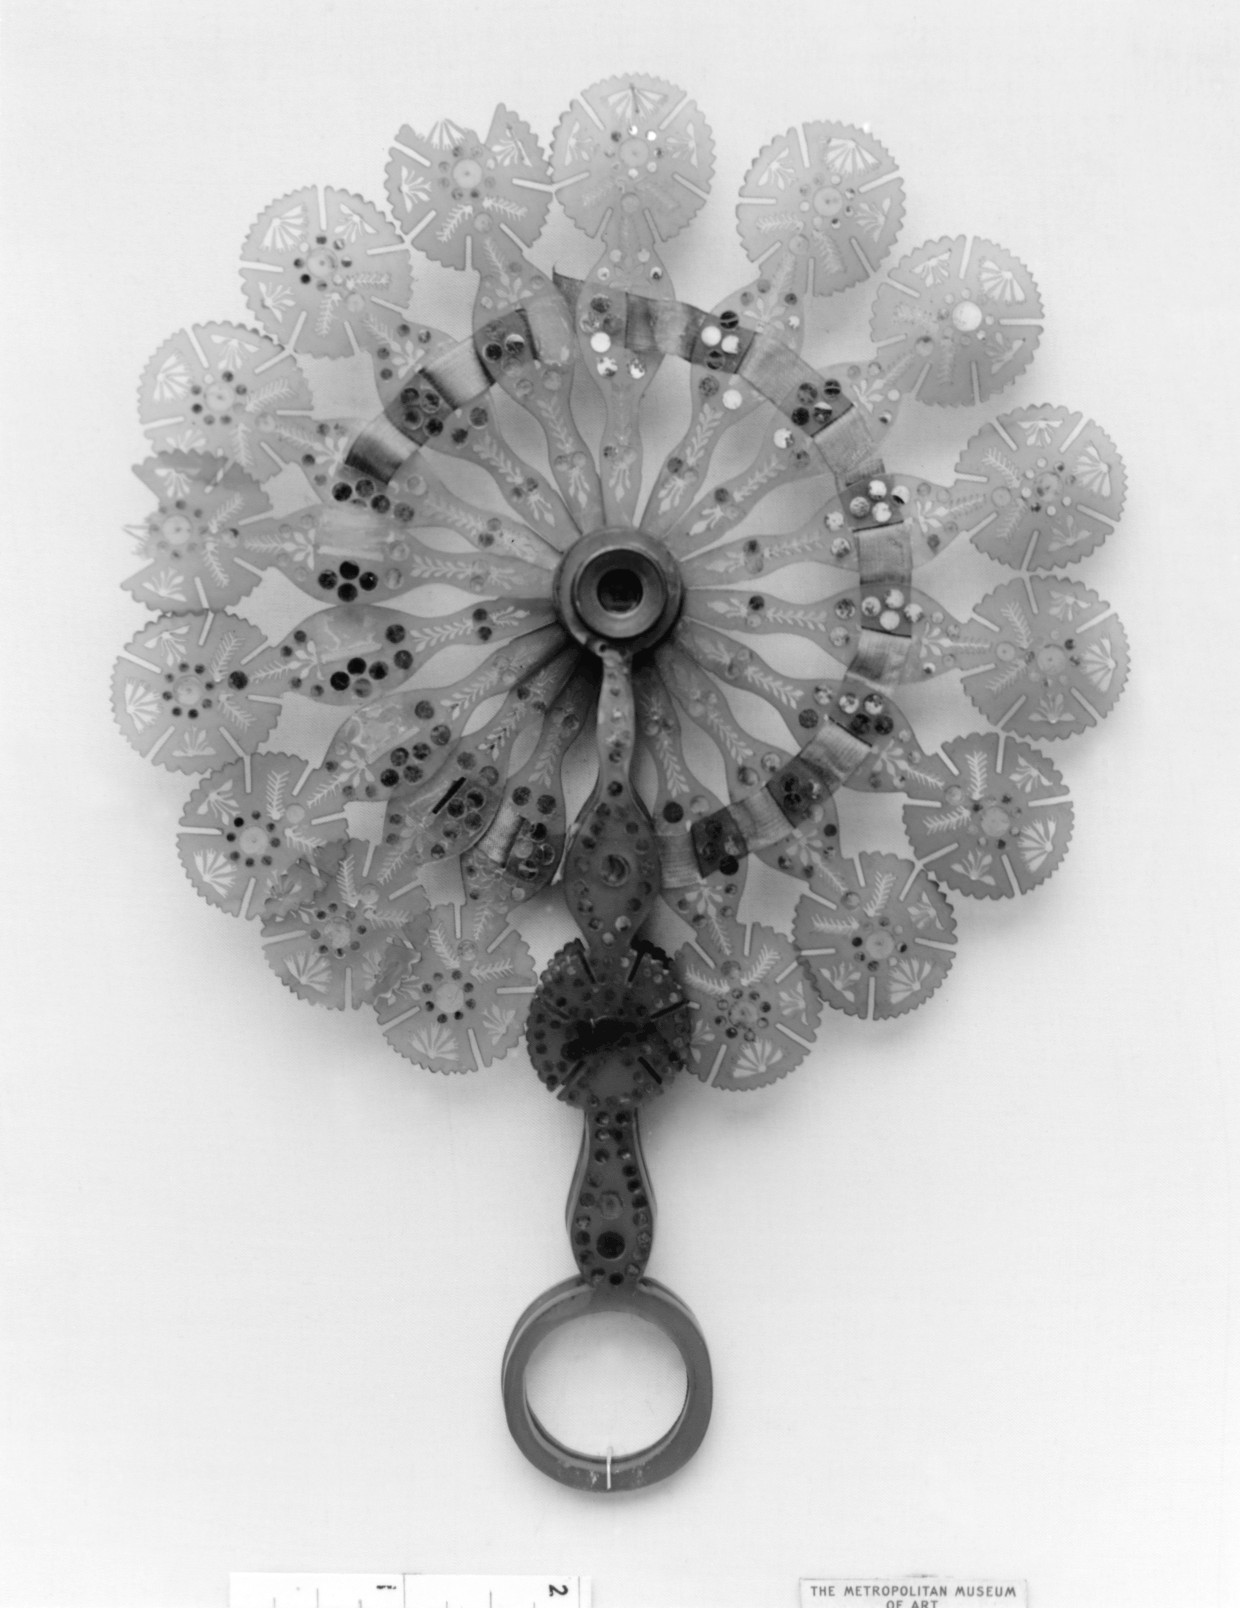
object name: fan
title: Lorgnette fan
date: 1801-1833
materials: horn